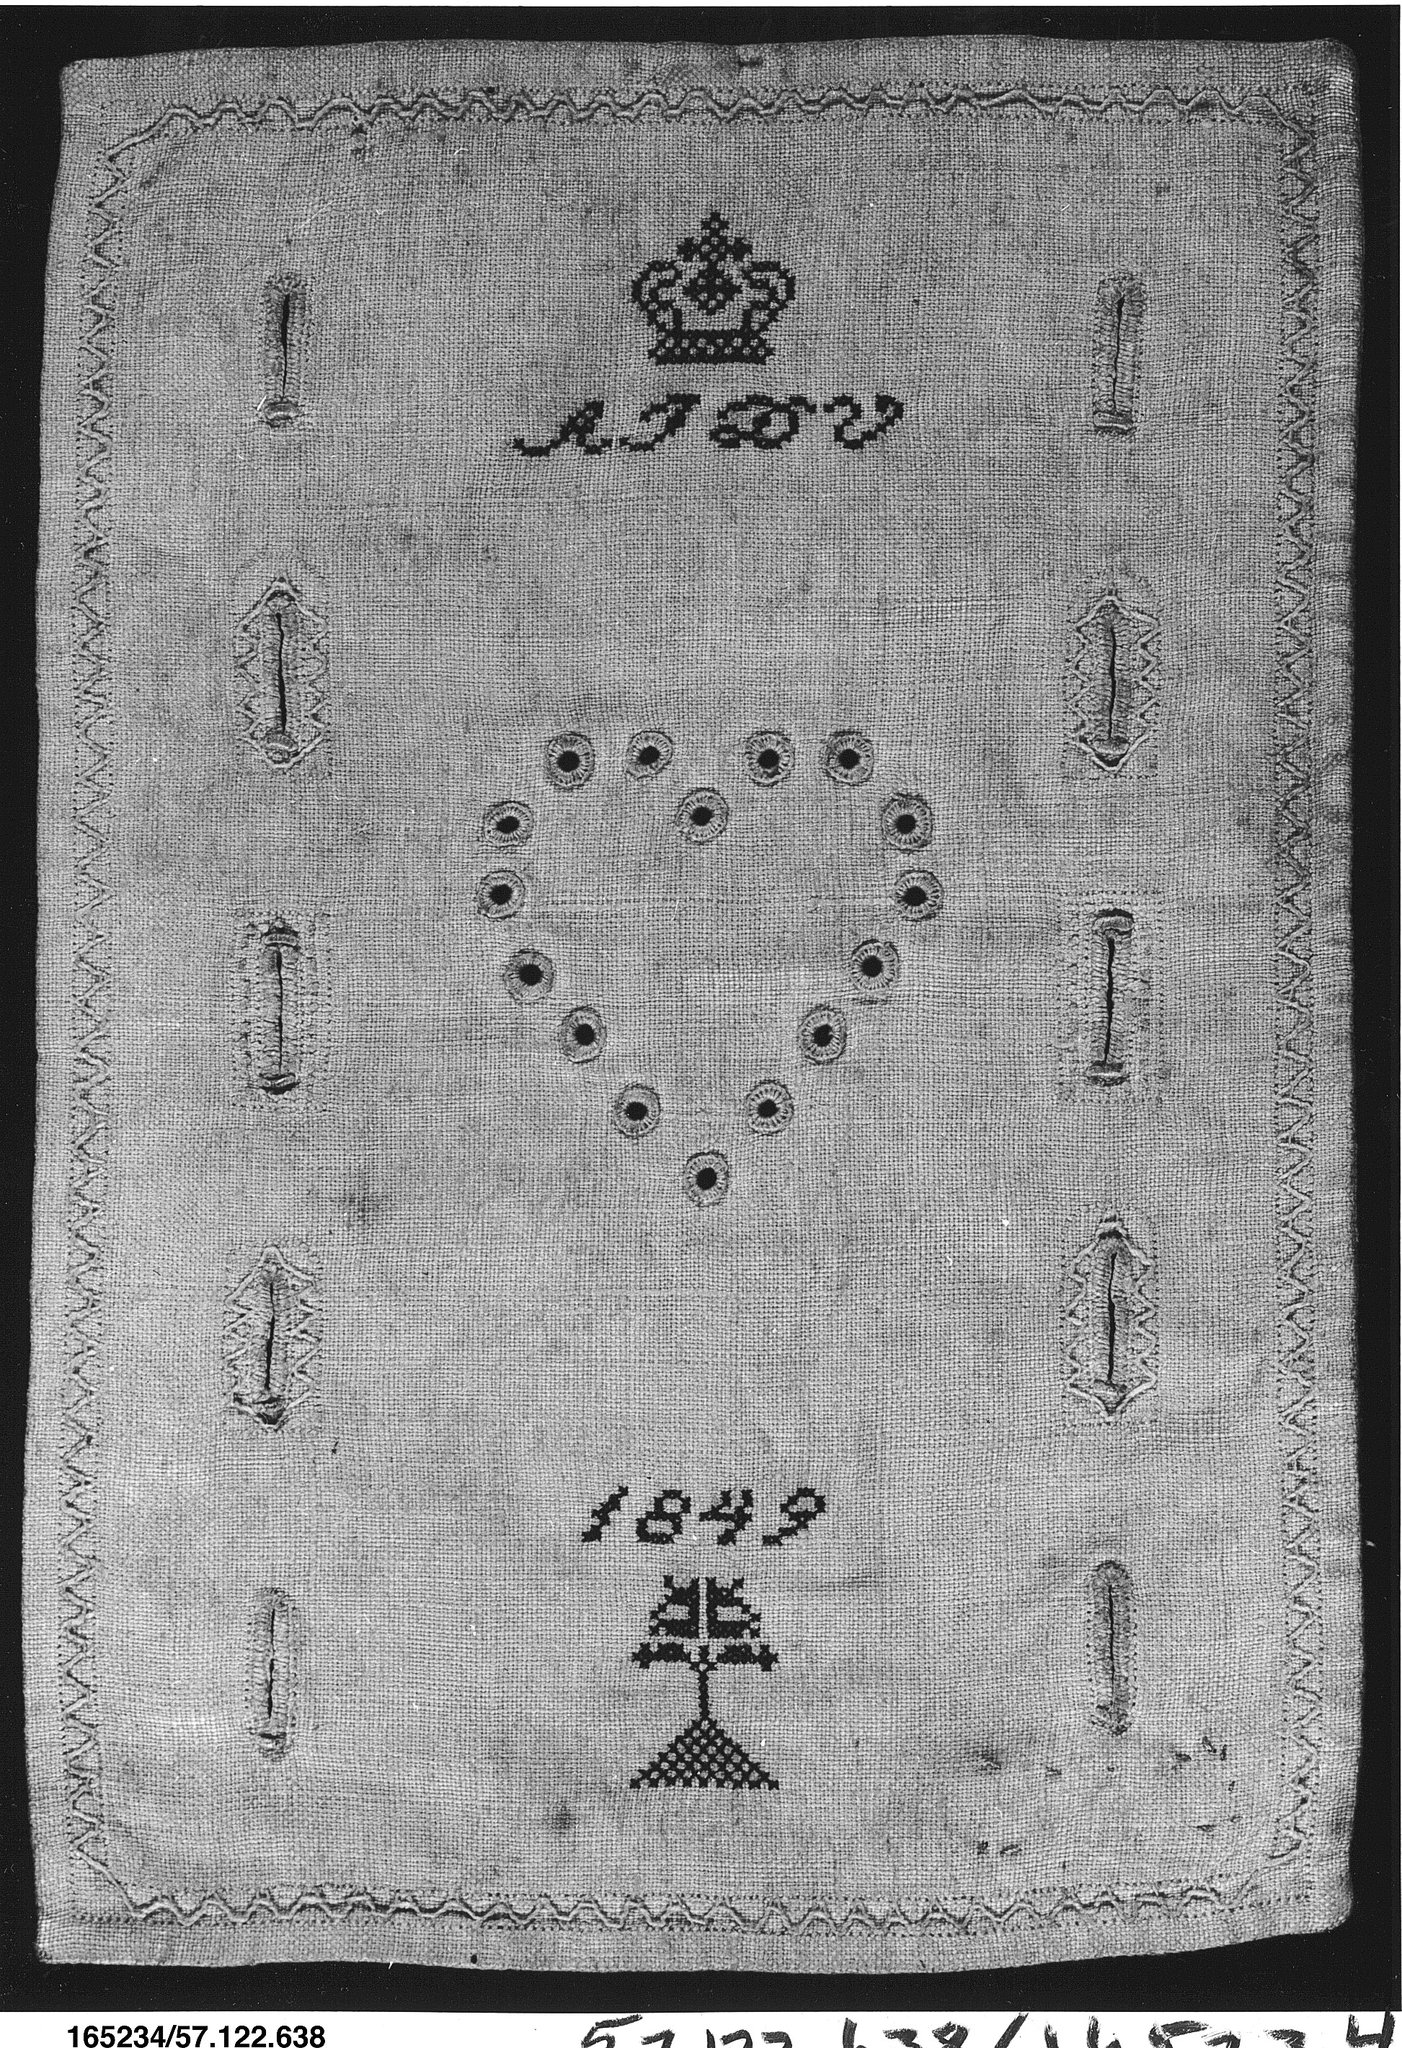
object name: sampler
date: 1849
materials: linen, silk